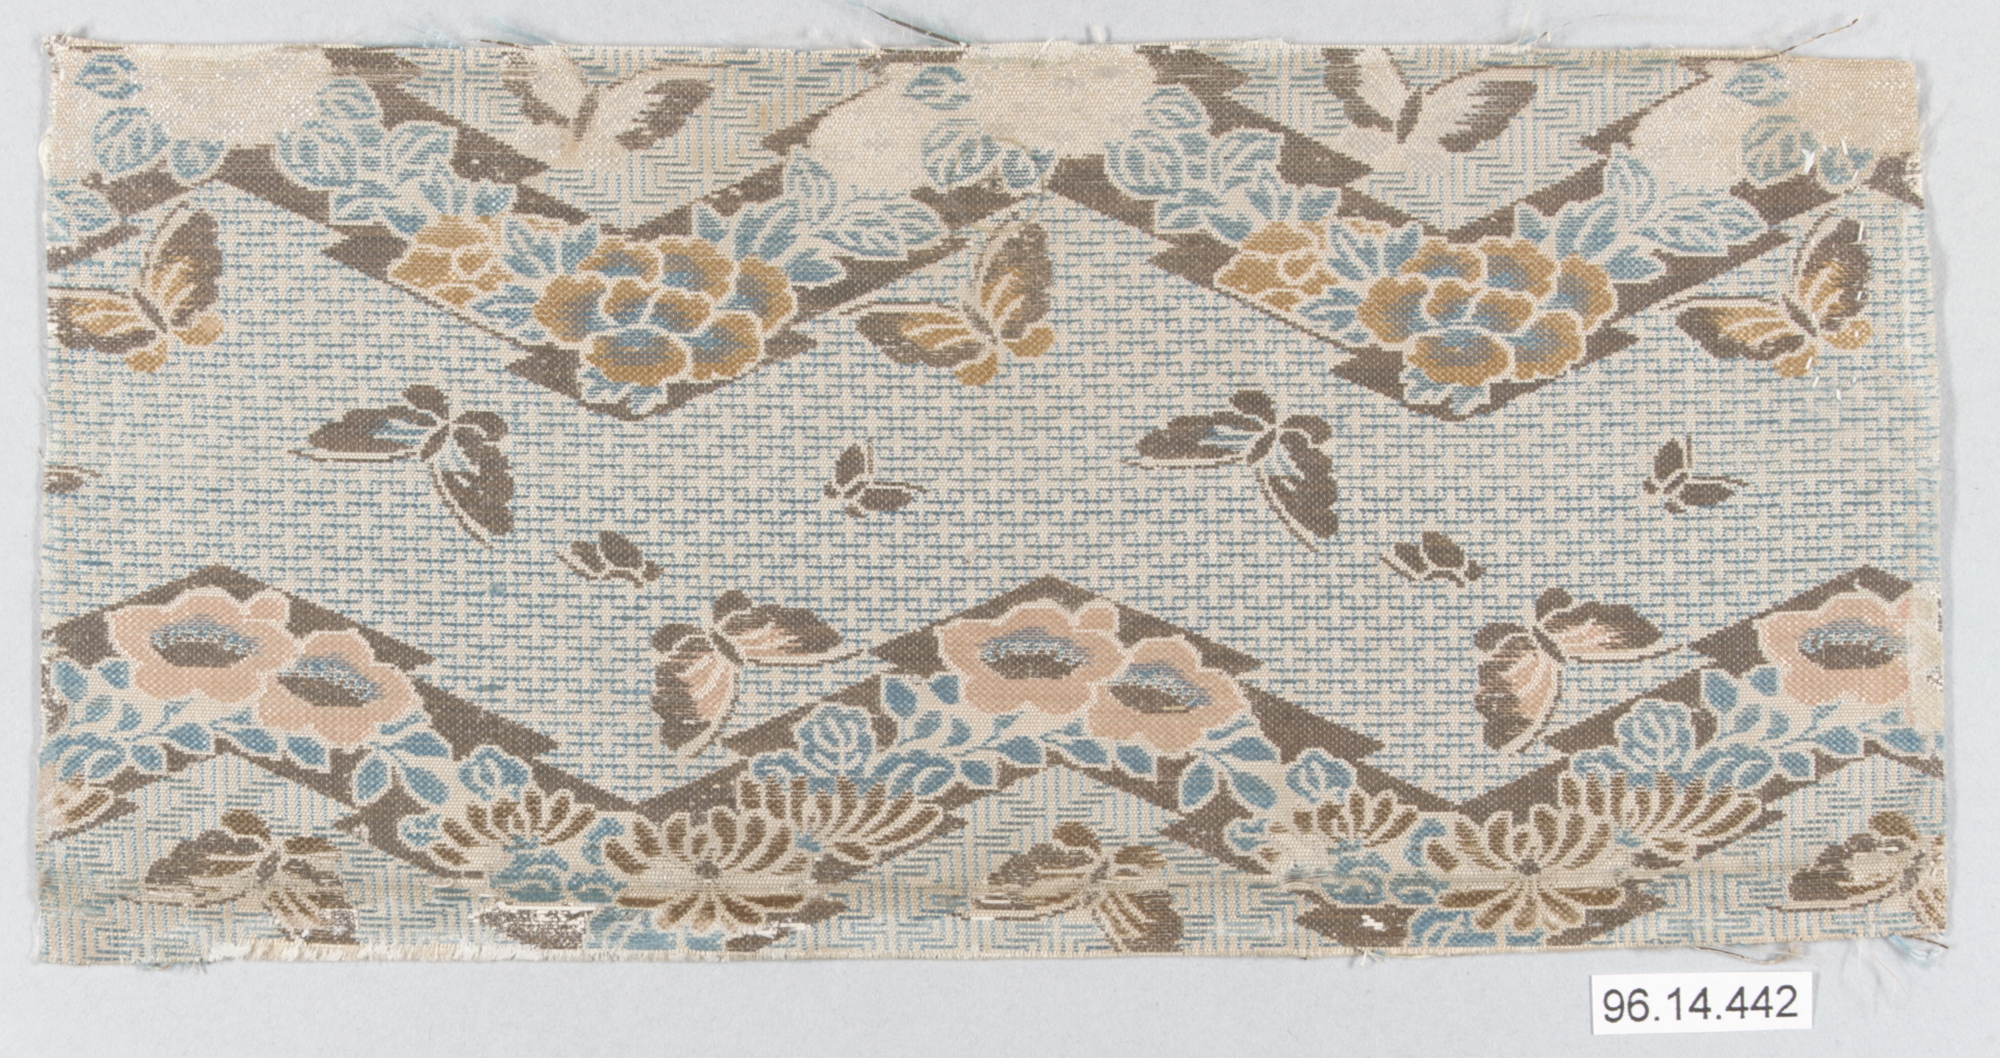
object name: piece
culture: japanese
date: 1701-1800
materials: metal thread, silk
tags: butterflies,leaves